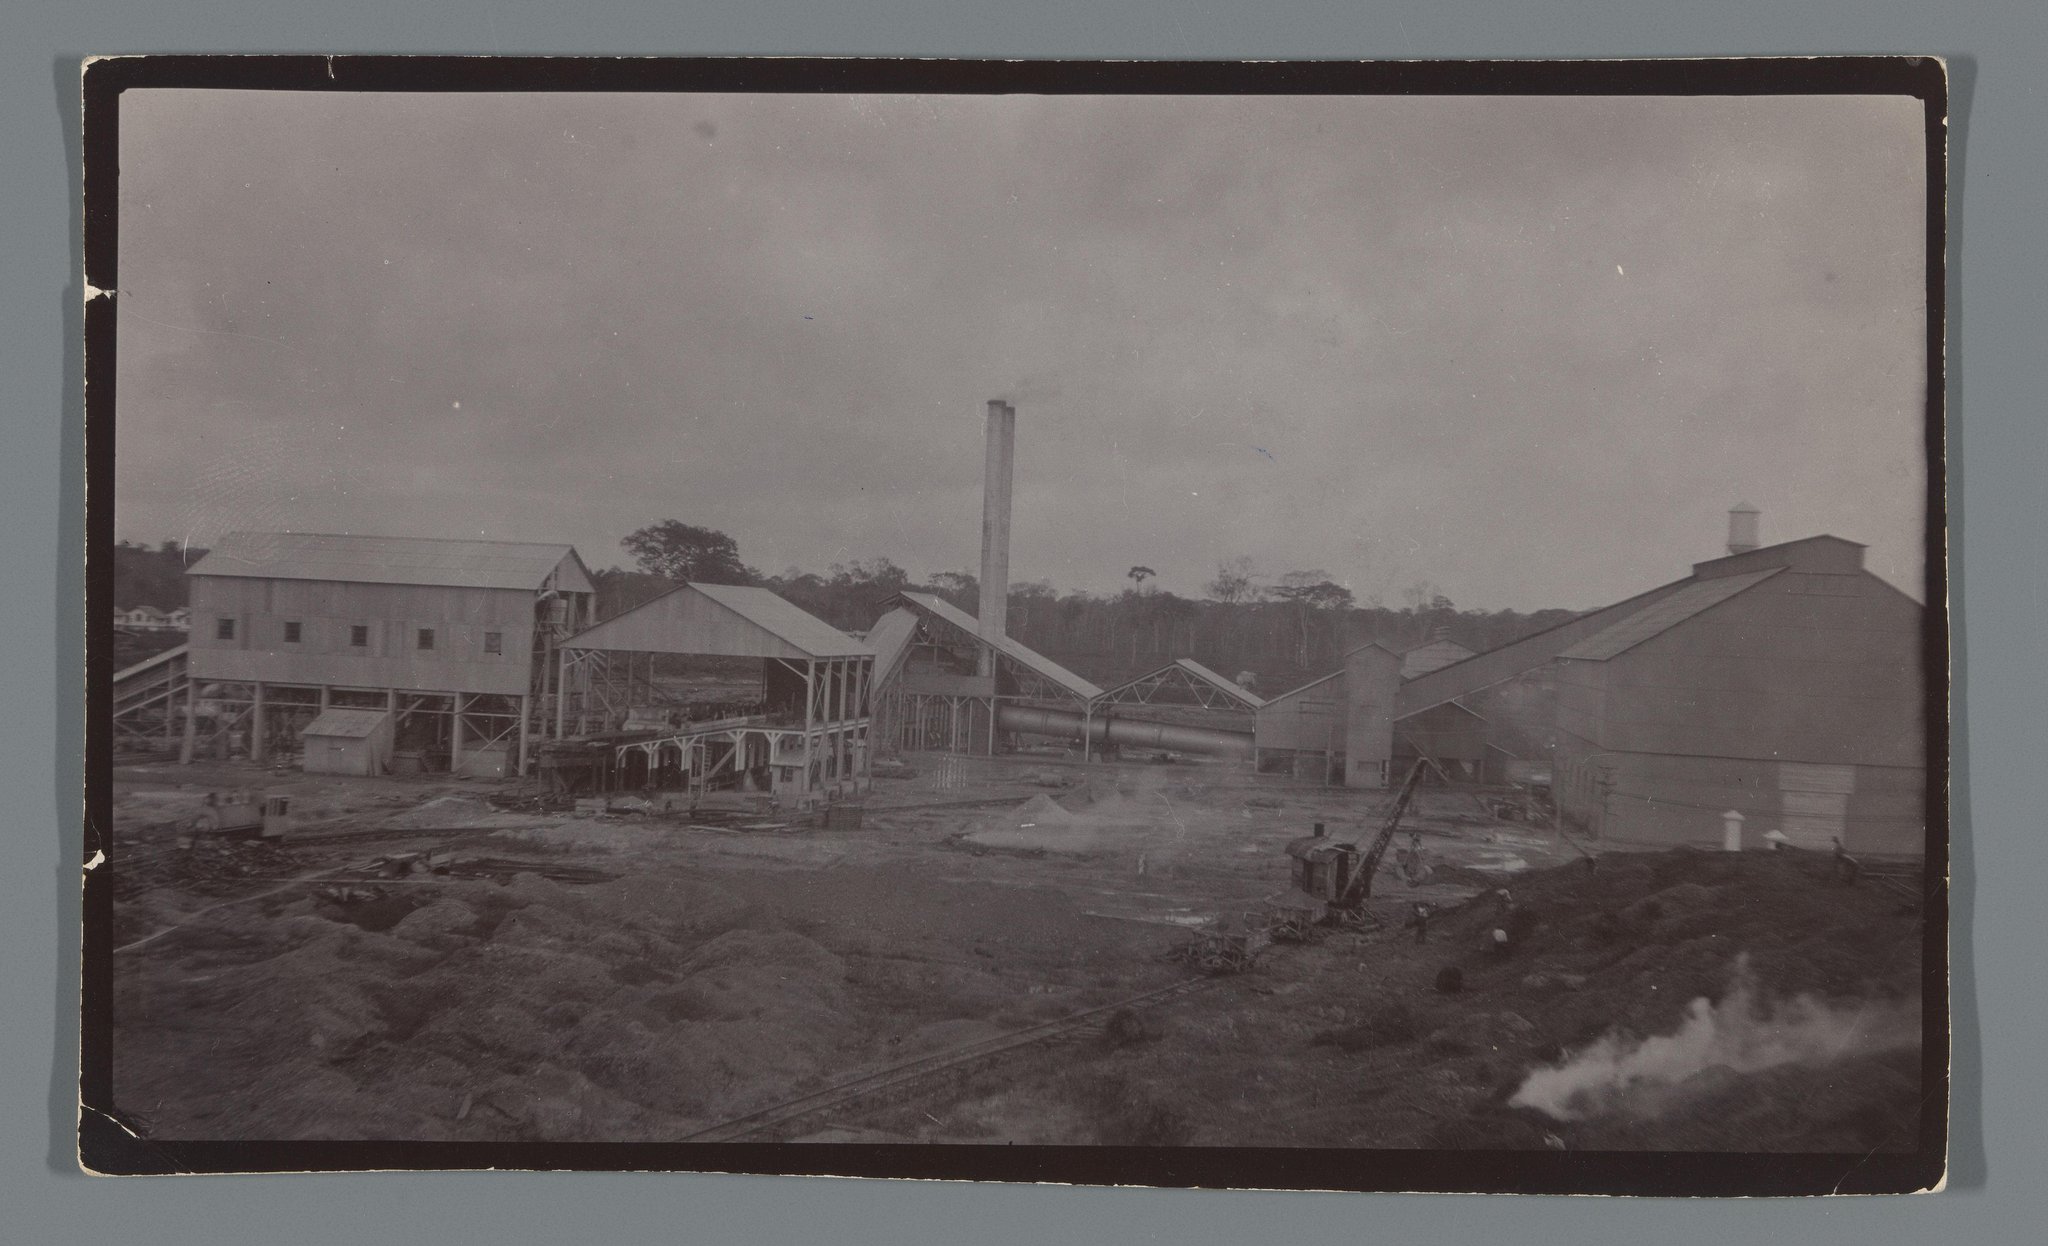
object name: photograph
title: Fabriek in Moengo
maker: Anonymous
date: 1925-1927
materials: photographic support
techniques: gelatin silver print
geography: suriname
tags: factory-building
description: Gezicht op de mijn en fabriek te Moengo. Onderdeel van het ensemble met foto's van de familie van ingenieur Jetten in de mijnbouwstad Moengo in Suriname.